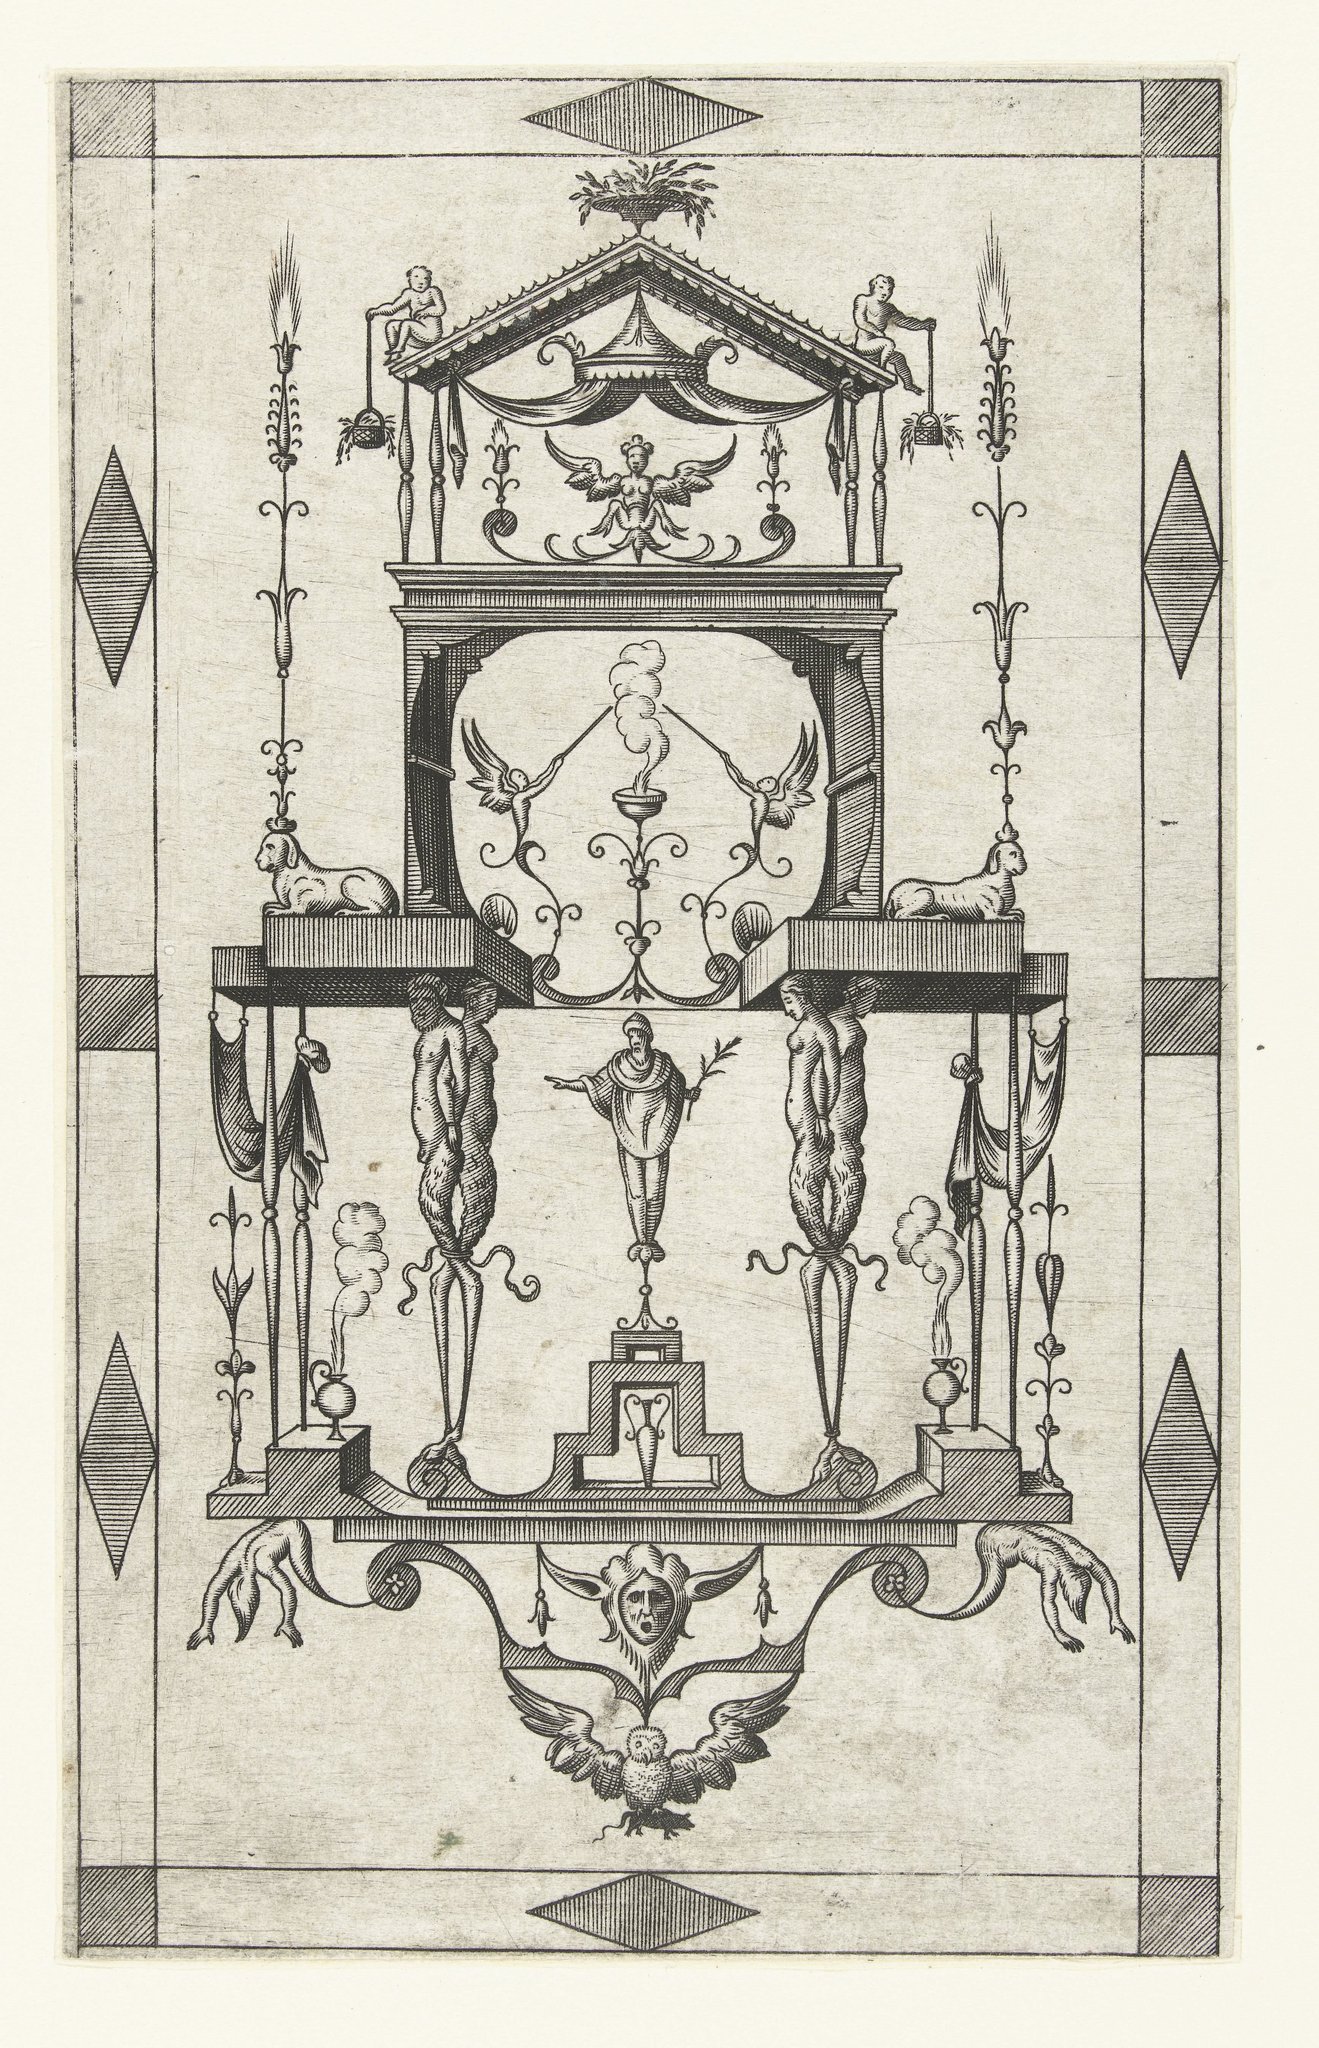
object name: print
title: Leviores et ut videtur extemporaneae picturae quas grotteschas vulgo vocant (...)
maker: Anonymous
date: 1530-1540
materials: paper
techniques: engraving, etching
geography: italy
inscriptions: collector's mark: Lugt 240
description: In het gebouw staat een figuur met een tak in de hand op een voetstuk. Uit serie van 20 bladen.